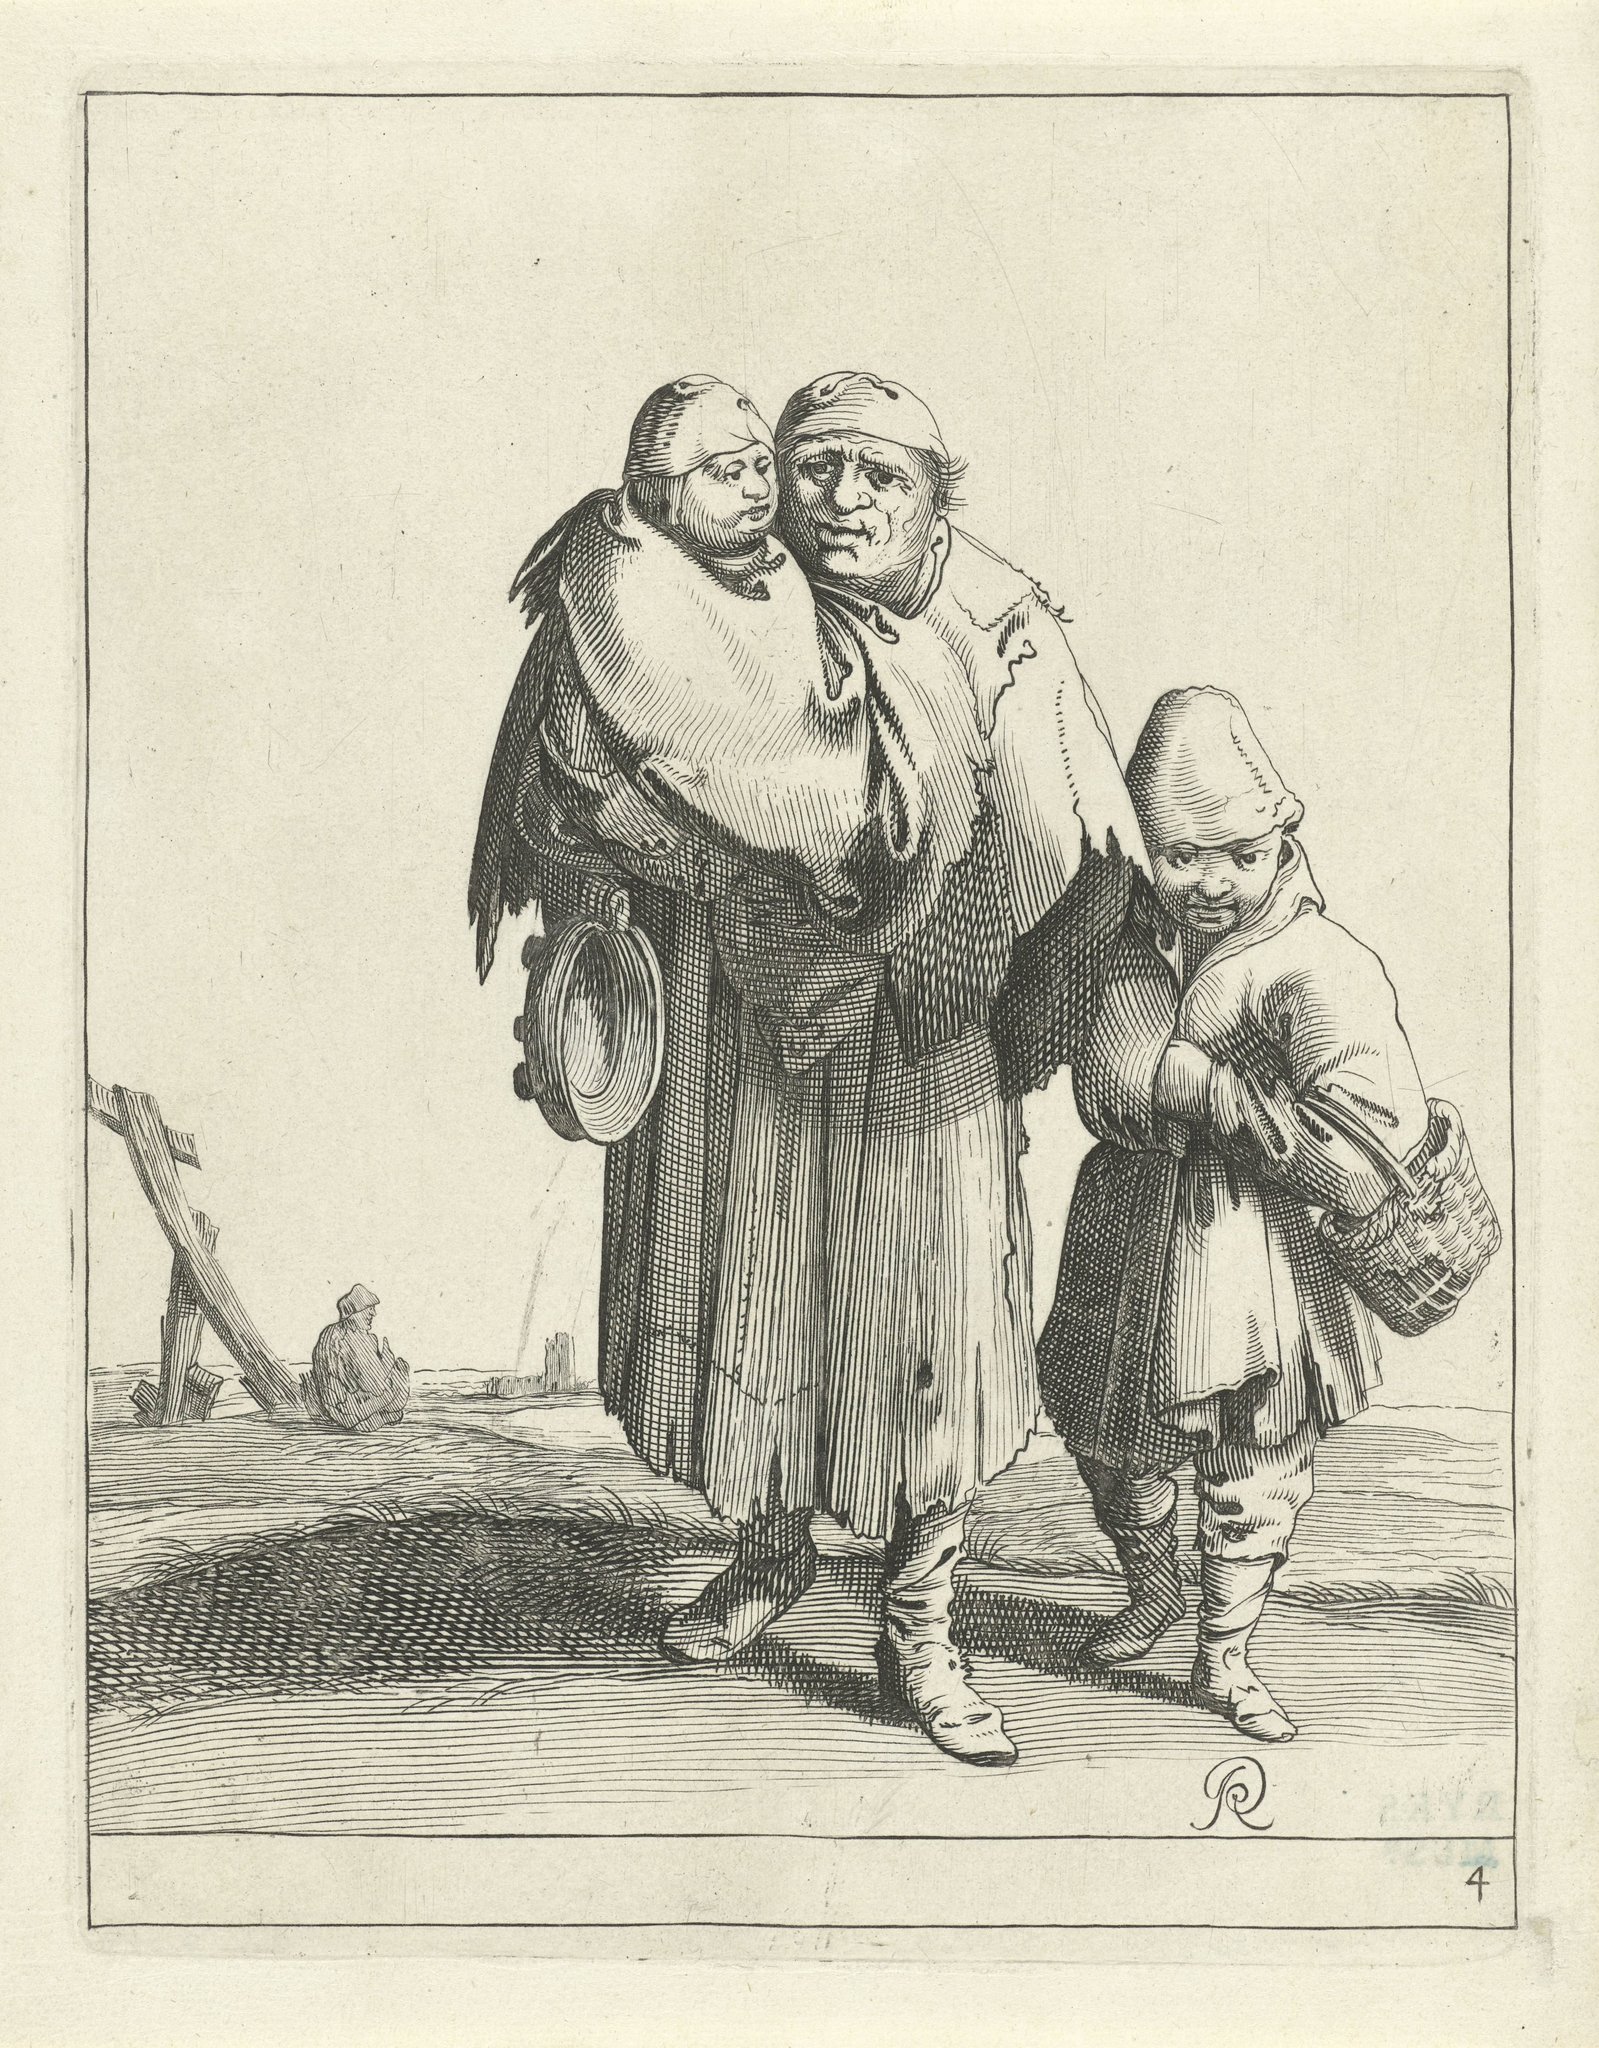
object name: print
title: Bedelaars en boeren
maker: pieter jansz quast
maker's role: draughtsman, painter, print maker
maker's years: 1605-1647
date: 1634-1638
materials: paper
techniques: engraving, etching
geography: the hague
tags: child, beggar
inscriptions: collector's mark: Lugt 2165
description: Een bedelaar draagt een kind en heeft een ander kind aan de arm. Links op de achtergrond zit een man. De prent maakt deel uit van een serie van zesentwintig prenten met bedelaars en boeren.